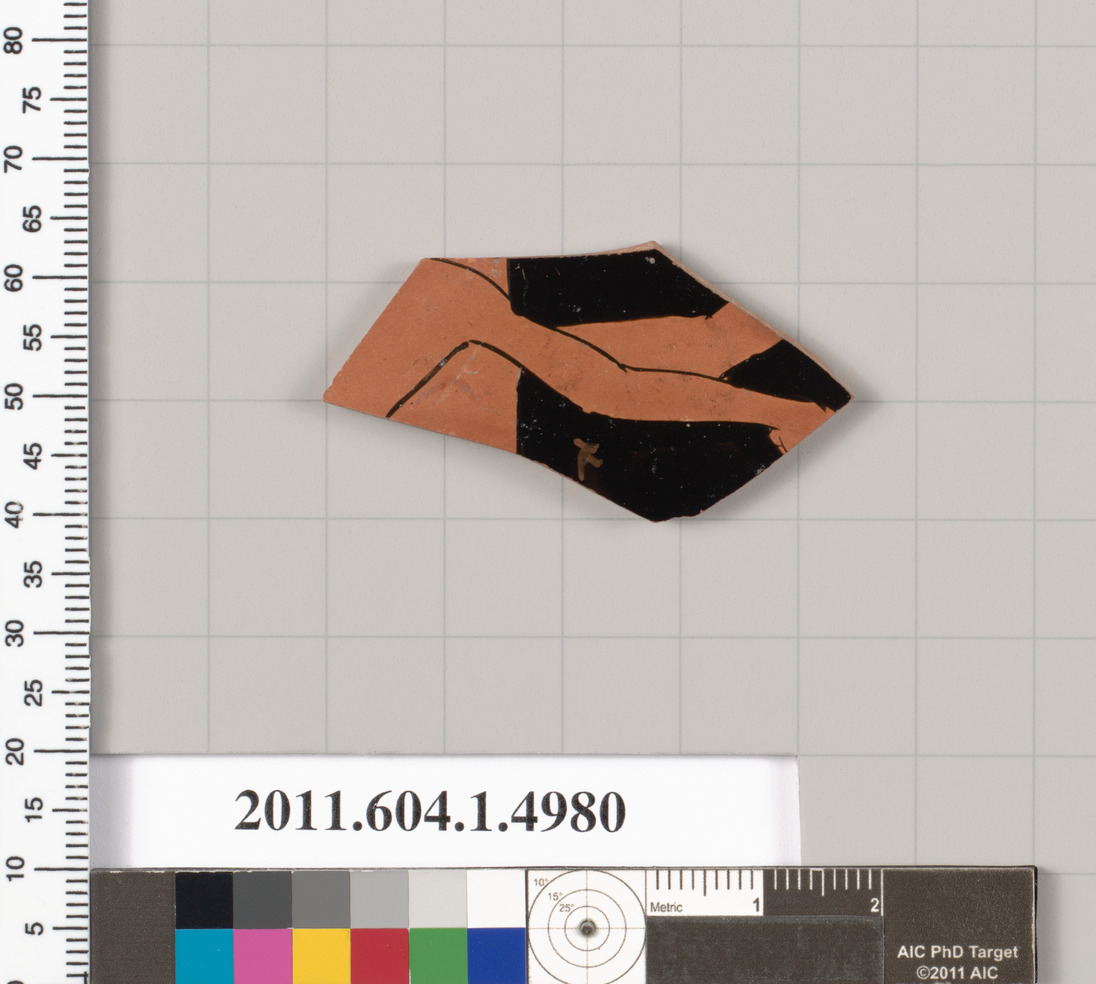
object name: kylix fragment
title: Terracotta fragment of a kylix (drinking cup)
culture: greek, attic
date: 520-500 BCE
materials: terracotta